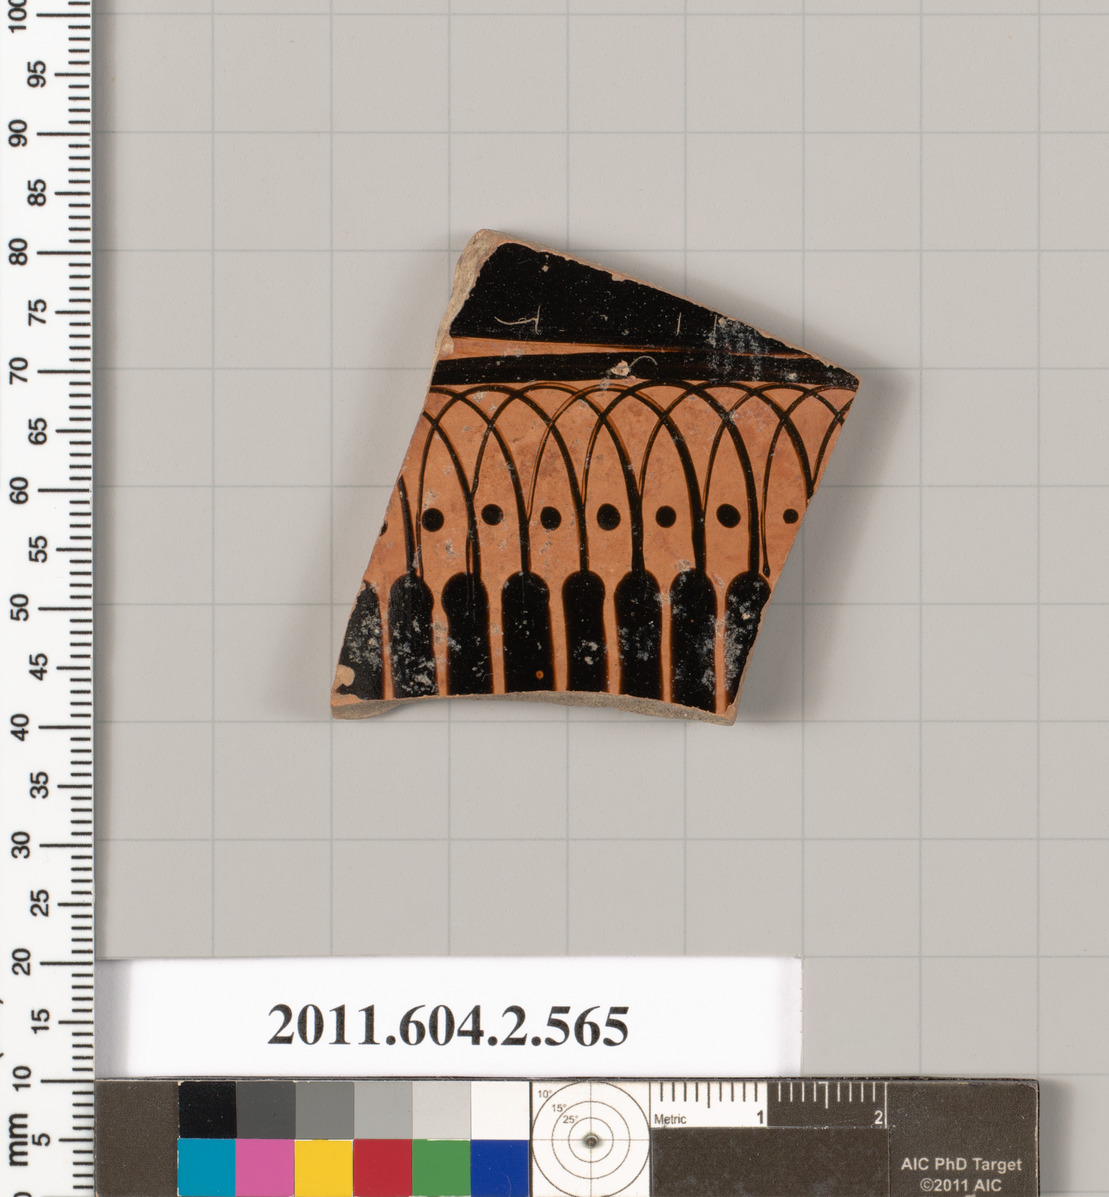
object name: column krater fragment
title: Terracotta fragment of a column-krater (bowl for mixing wine and water)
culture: greek, attic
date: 460-440 BCE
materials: terracotta